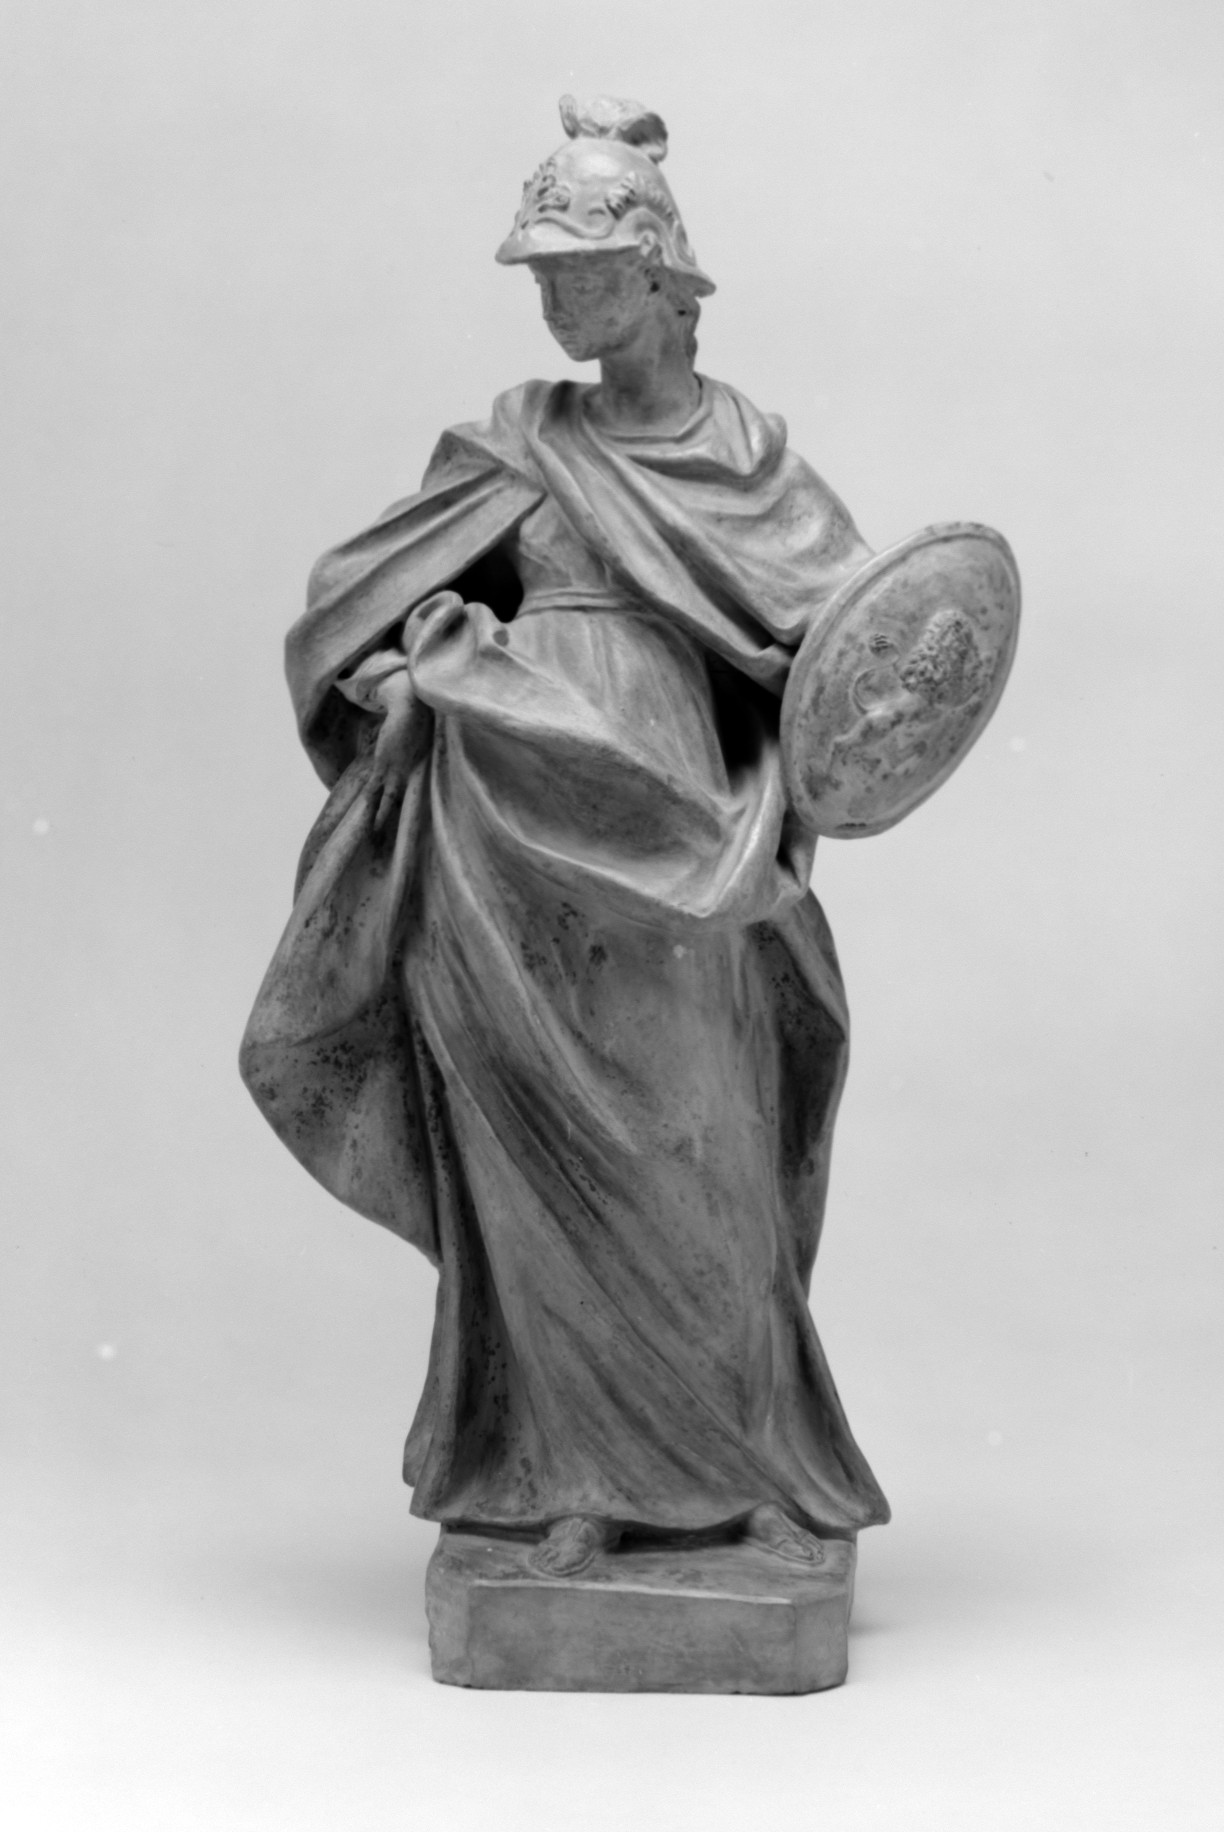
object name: statuette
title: Fortitude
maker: angelo piò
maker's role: artist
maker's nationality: italian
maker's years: 1690-1770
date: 1740-1750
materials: terracotta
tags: shields,women